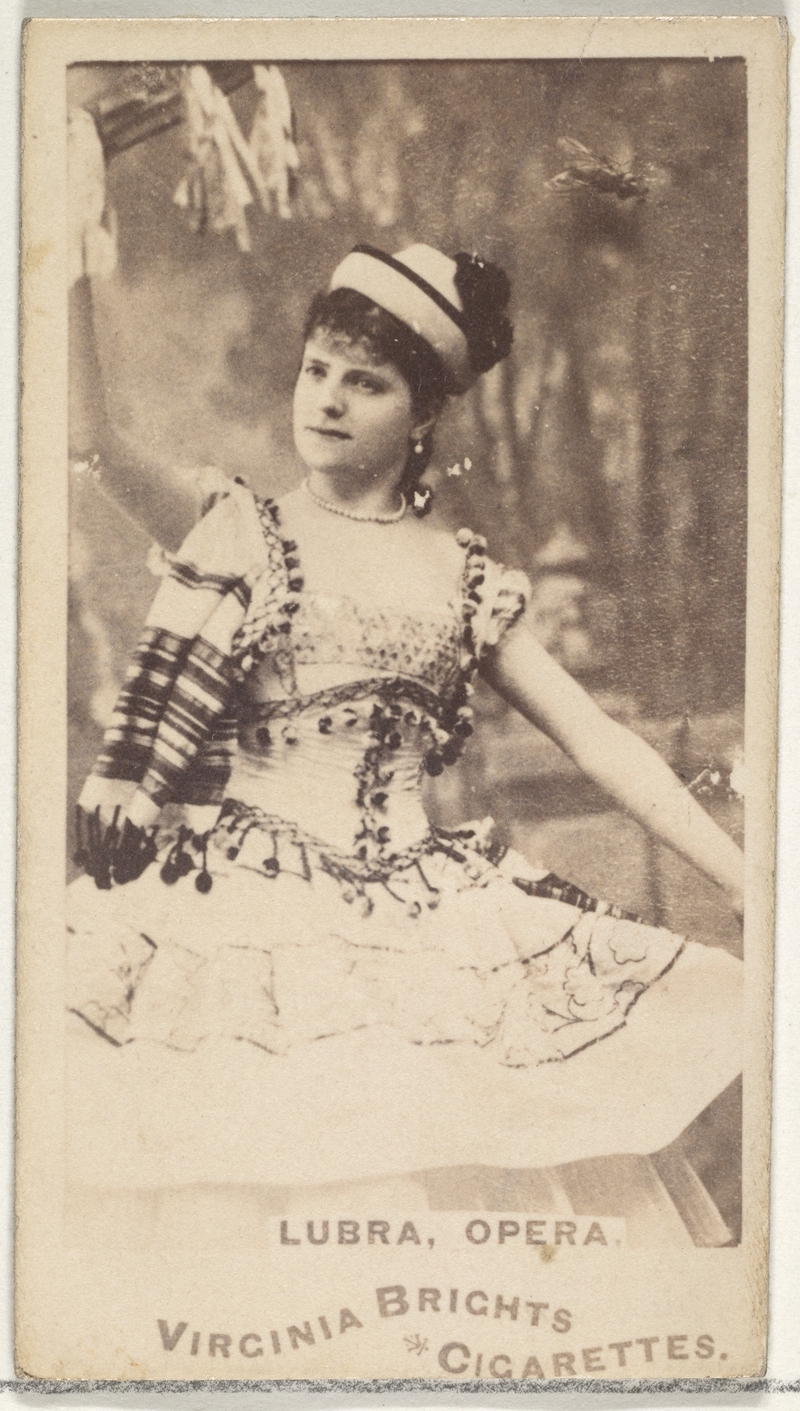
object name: photograph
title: Lubra, Opera, from the Actors and Actresses series (N45, Type 1) for Virginia Brights Cigarettes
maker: allen & ginter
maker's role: publisher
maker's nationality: american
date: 1888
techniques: albumen silver print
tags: portraits,women,actresses